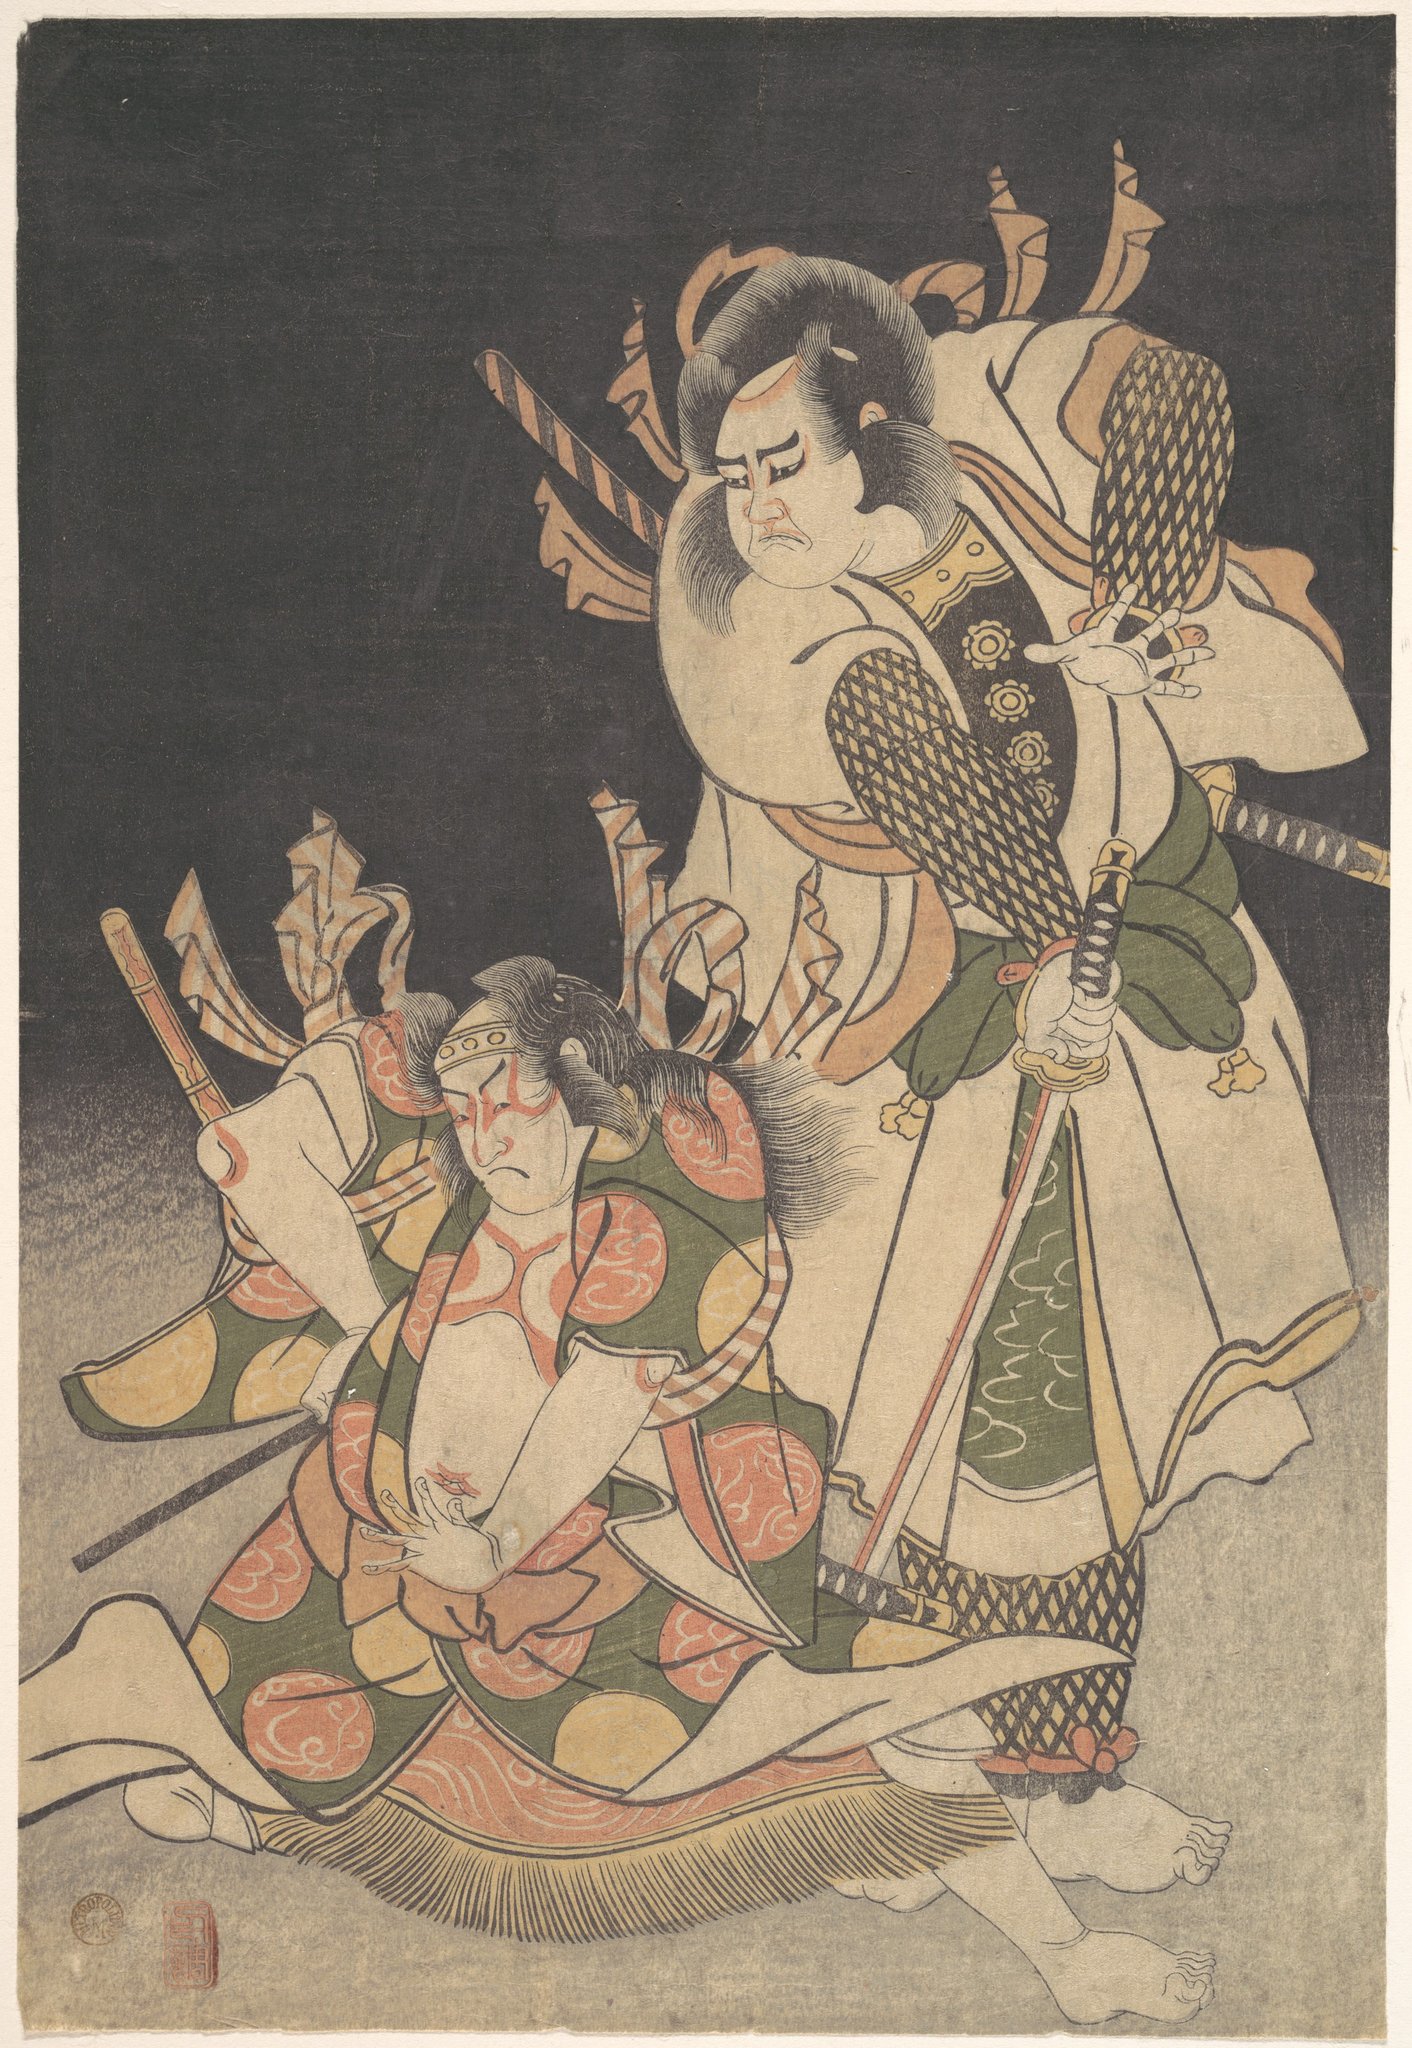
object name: woodblock print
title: Scene from a Drama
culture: japanese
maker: unidentified artist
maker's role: artist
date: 1615-1868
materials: ink, paper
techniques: woodblock print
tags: swords,men,actors